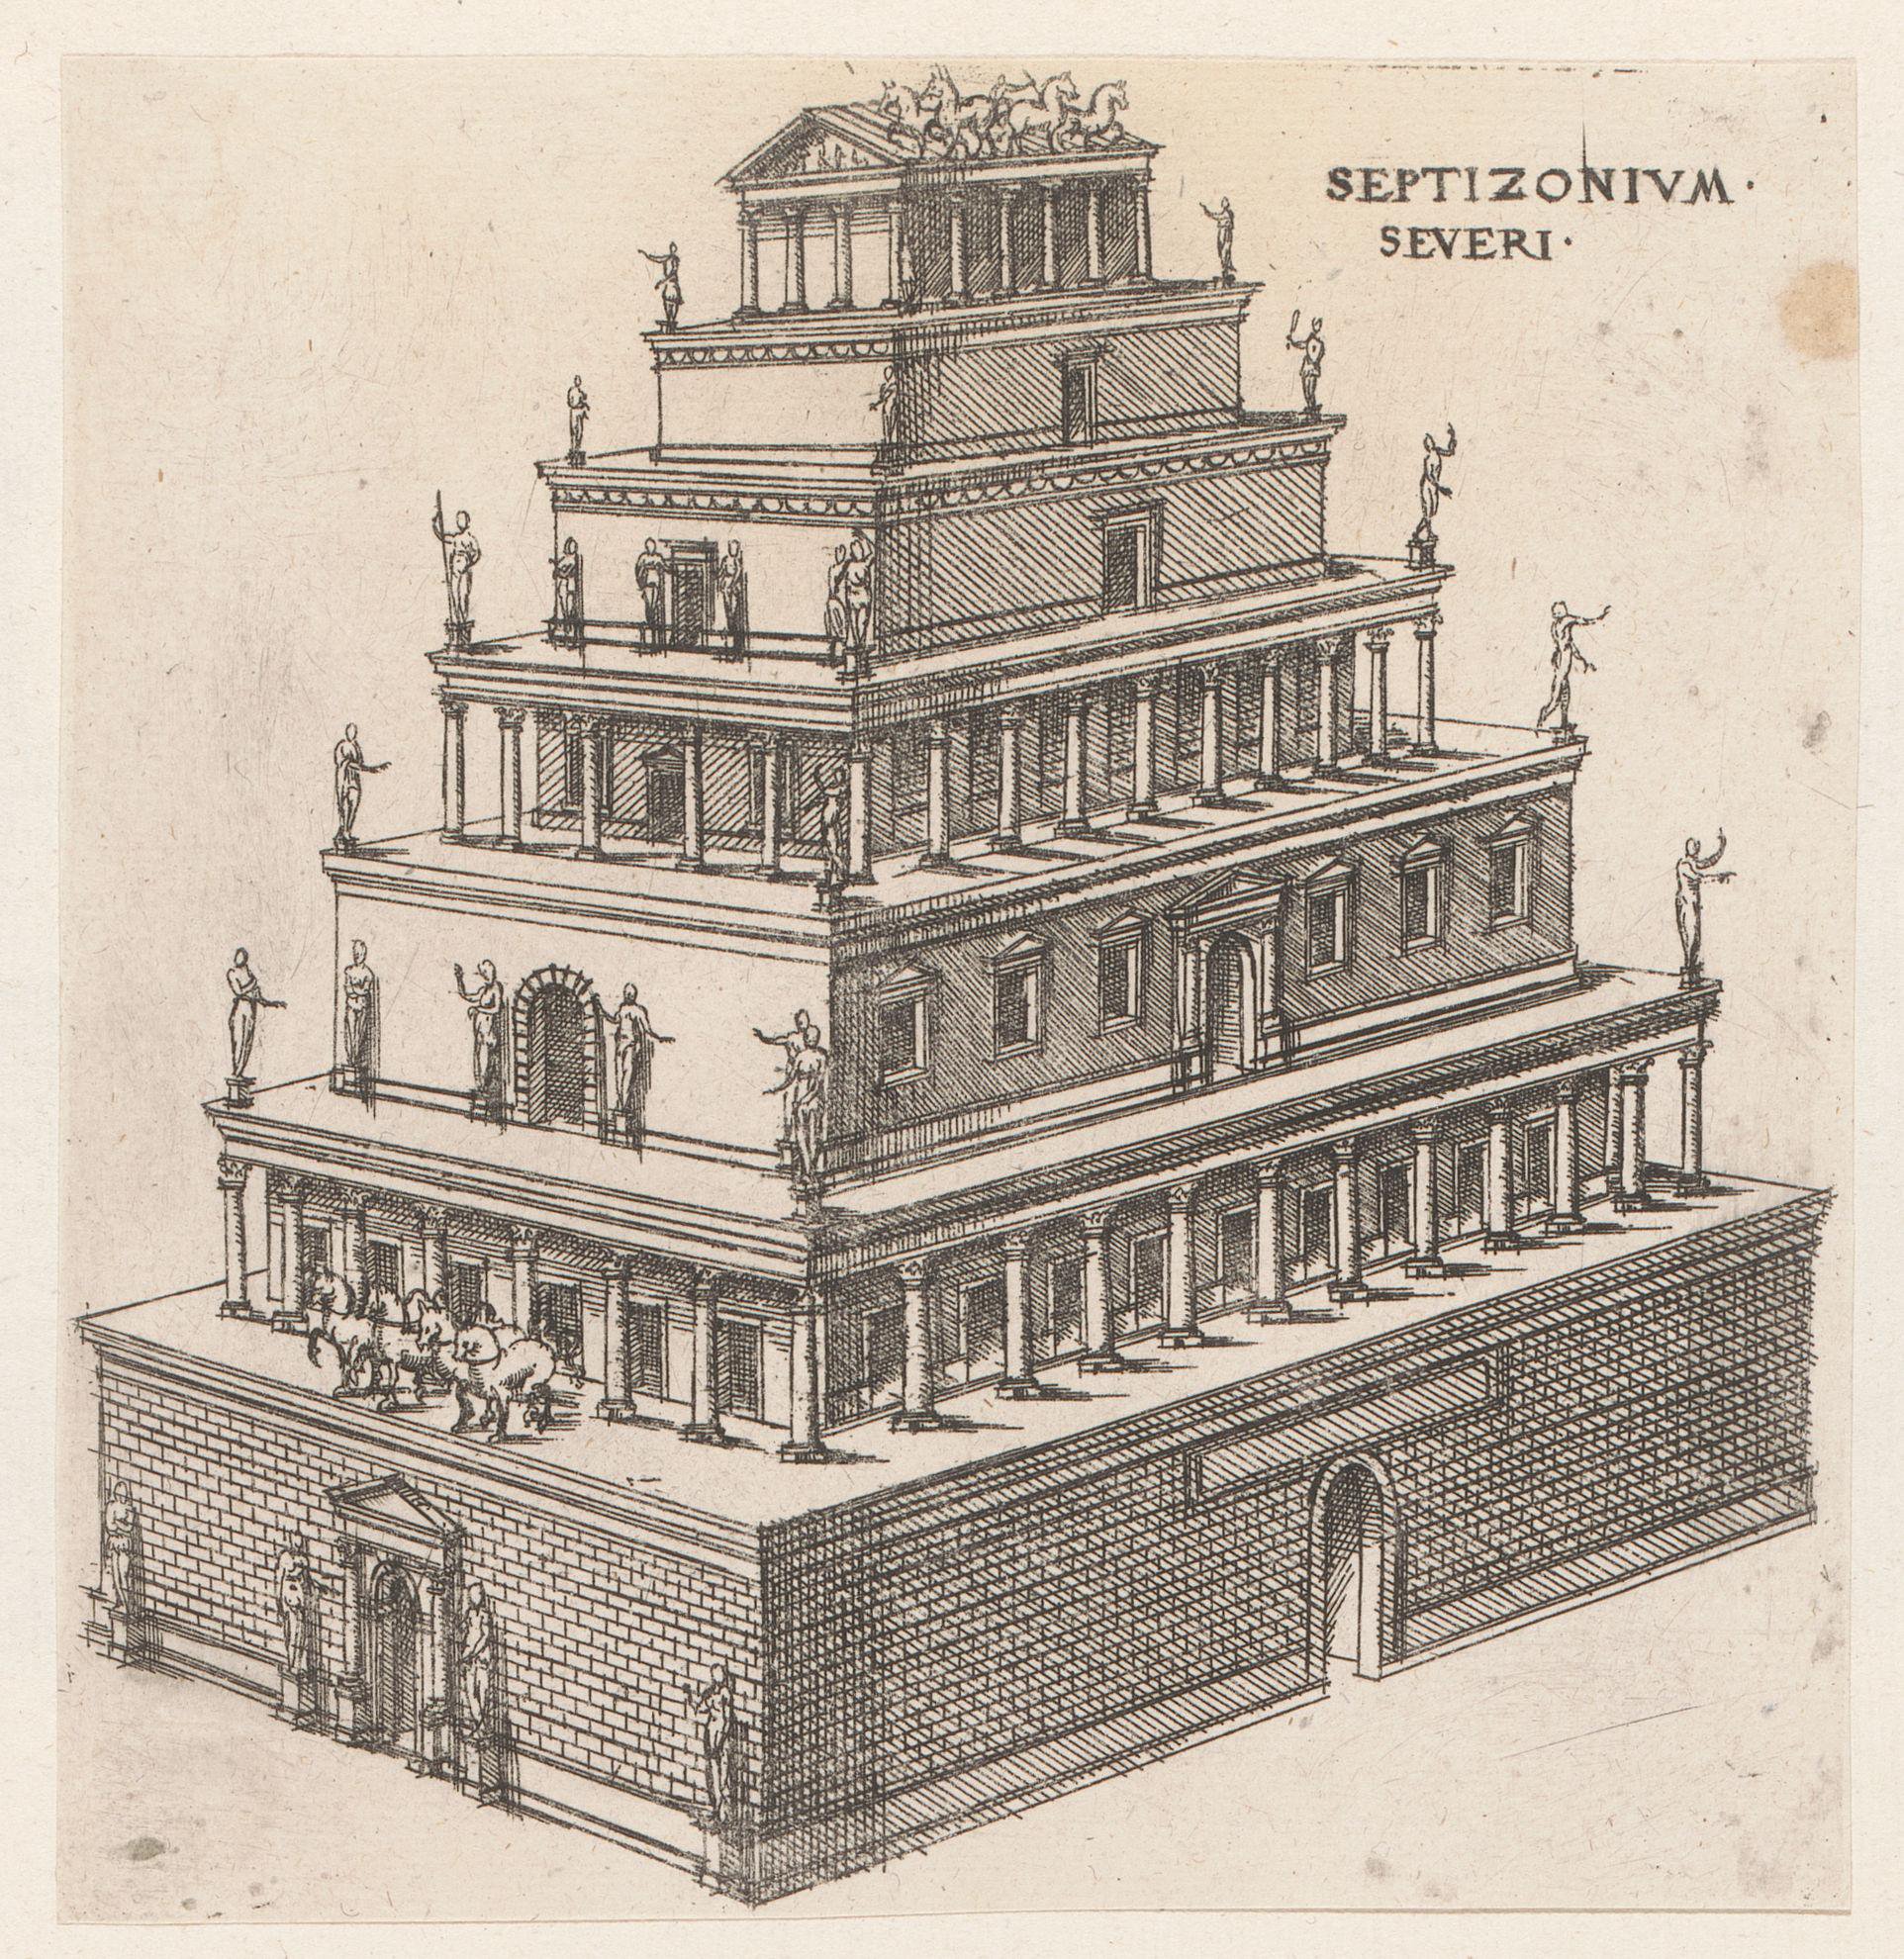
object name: print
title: Livre des edifices antiques romains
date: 1584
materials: paper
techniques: etching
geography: france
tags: monument, statue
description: Deze prent maakt deel uit van een serie van 98 prenten gedrukt op 48 bladen. De bladen zijn verknipt en een selectie van de losse prenten is in dit album geplakt.